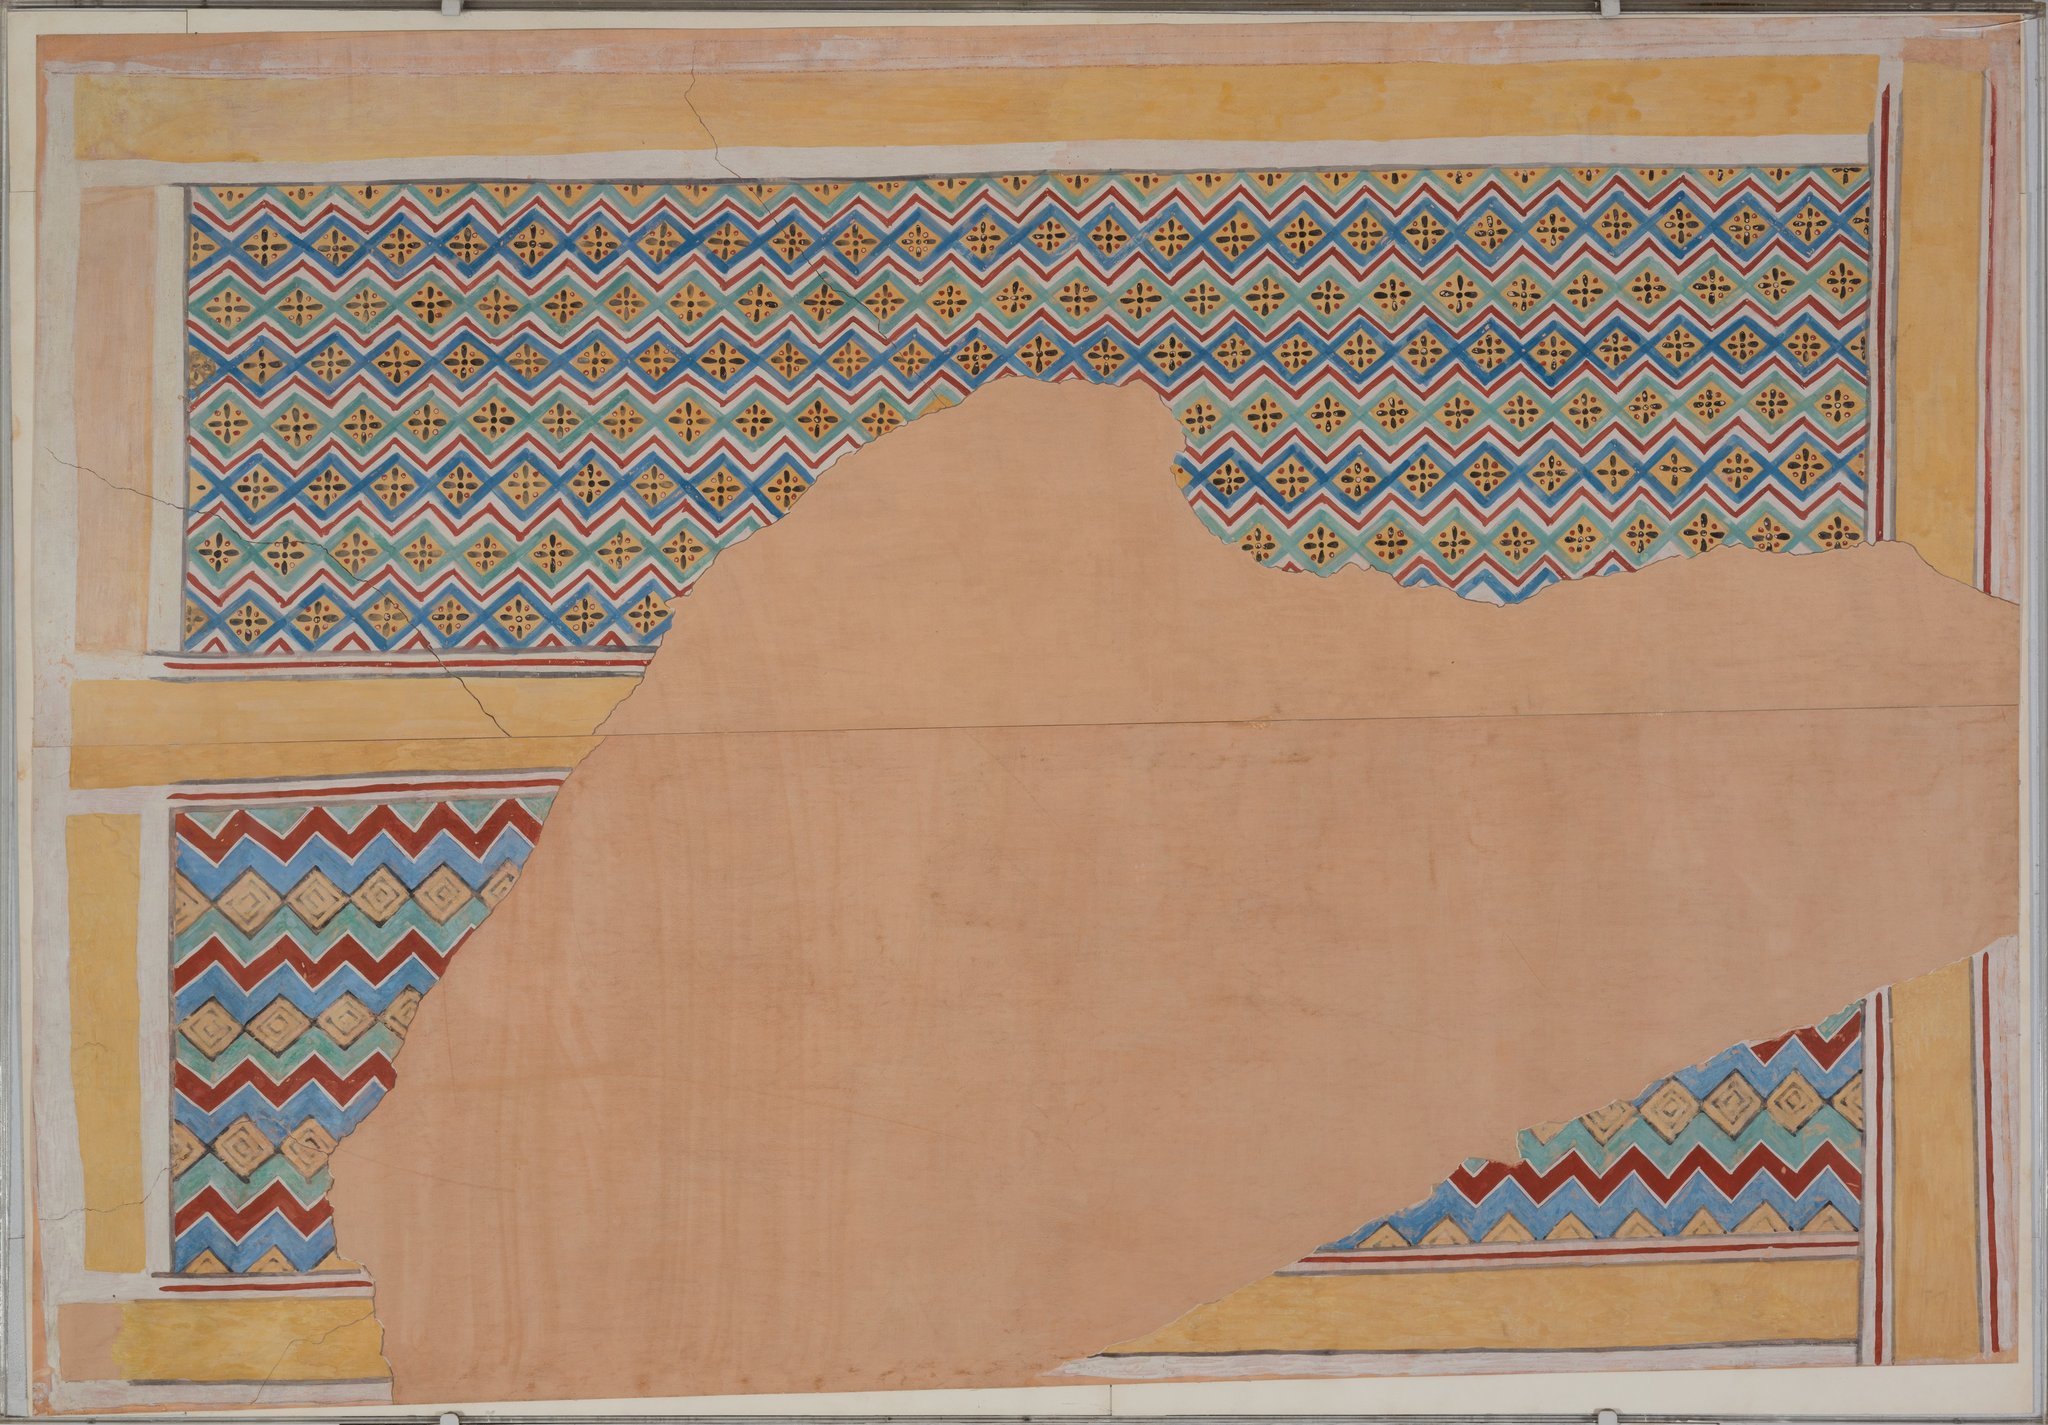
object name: facsimile, nakht tt 52, ceiling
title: Ceiling on the South Side of the Transverse Hall of Nakht's Offering Chapel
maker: lancelot crane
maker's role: artist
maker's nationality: british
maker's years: 1880-1918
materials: paper, paint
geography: egypt